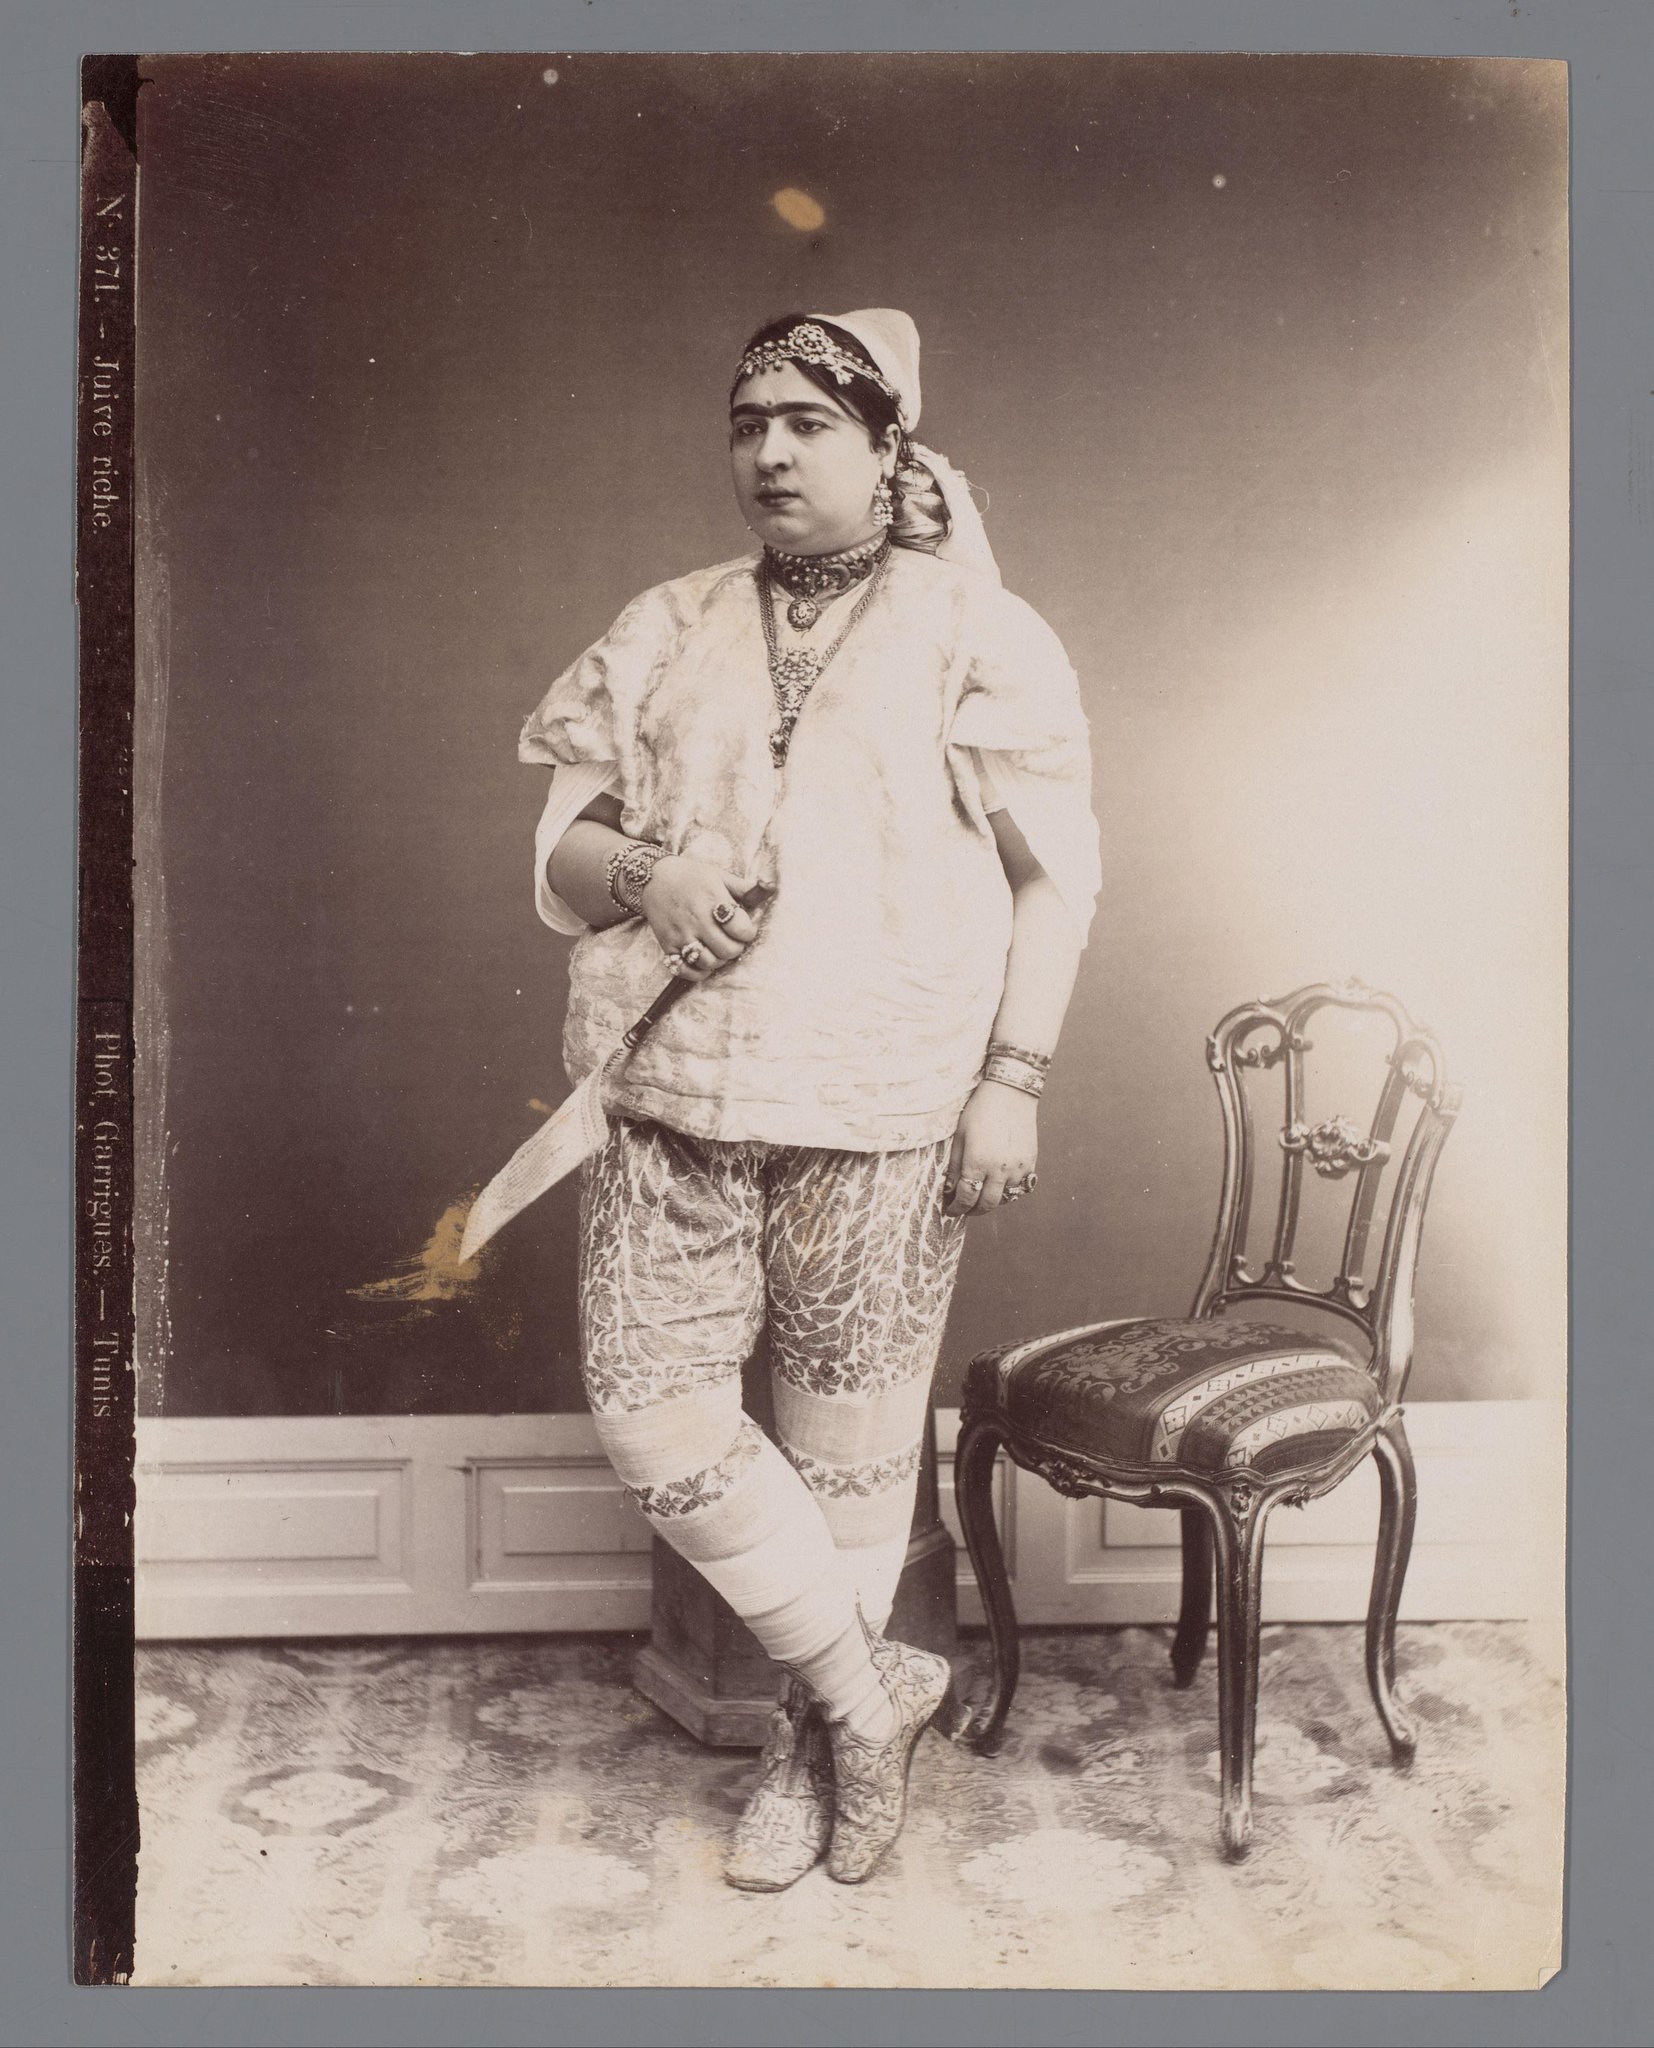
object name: photograph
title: Portret van een onbekende Joodse vrouw met mes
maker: j. andré garrigues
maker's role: fotograaf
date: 1860-1900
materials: paper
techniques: albumen print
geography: middle east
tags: adult woman, anonymous historical person portrayed, tools, aids, implements ~ crafts and industries: knife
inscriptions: number: ‘N. 371.’